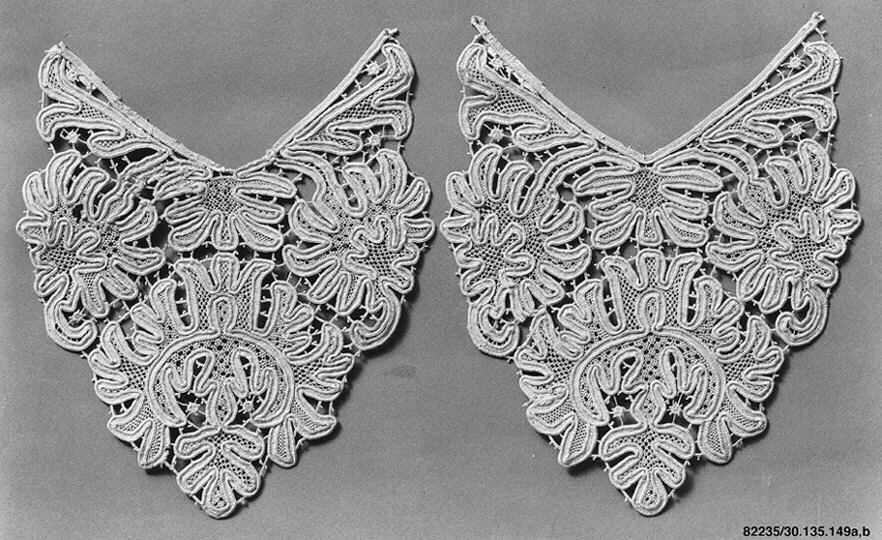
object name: ornament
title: Ornament (one of a pair)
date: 1600-1650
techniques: lace